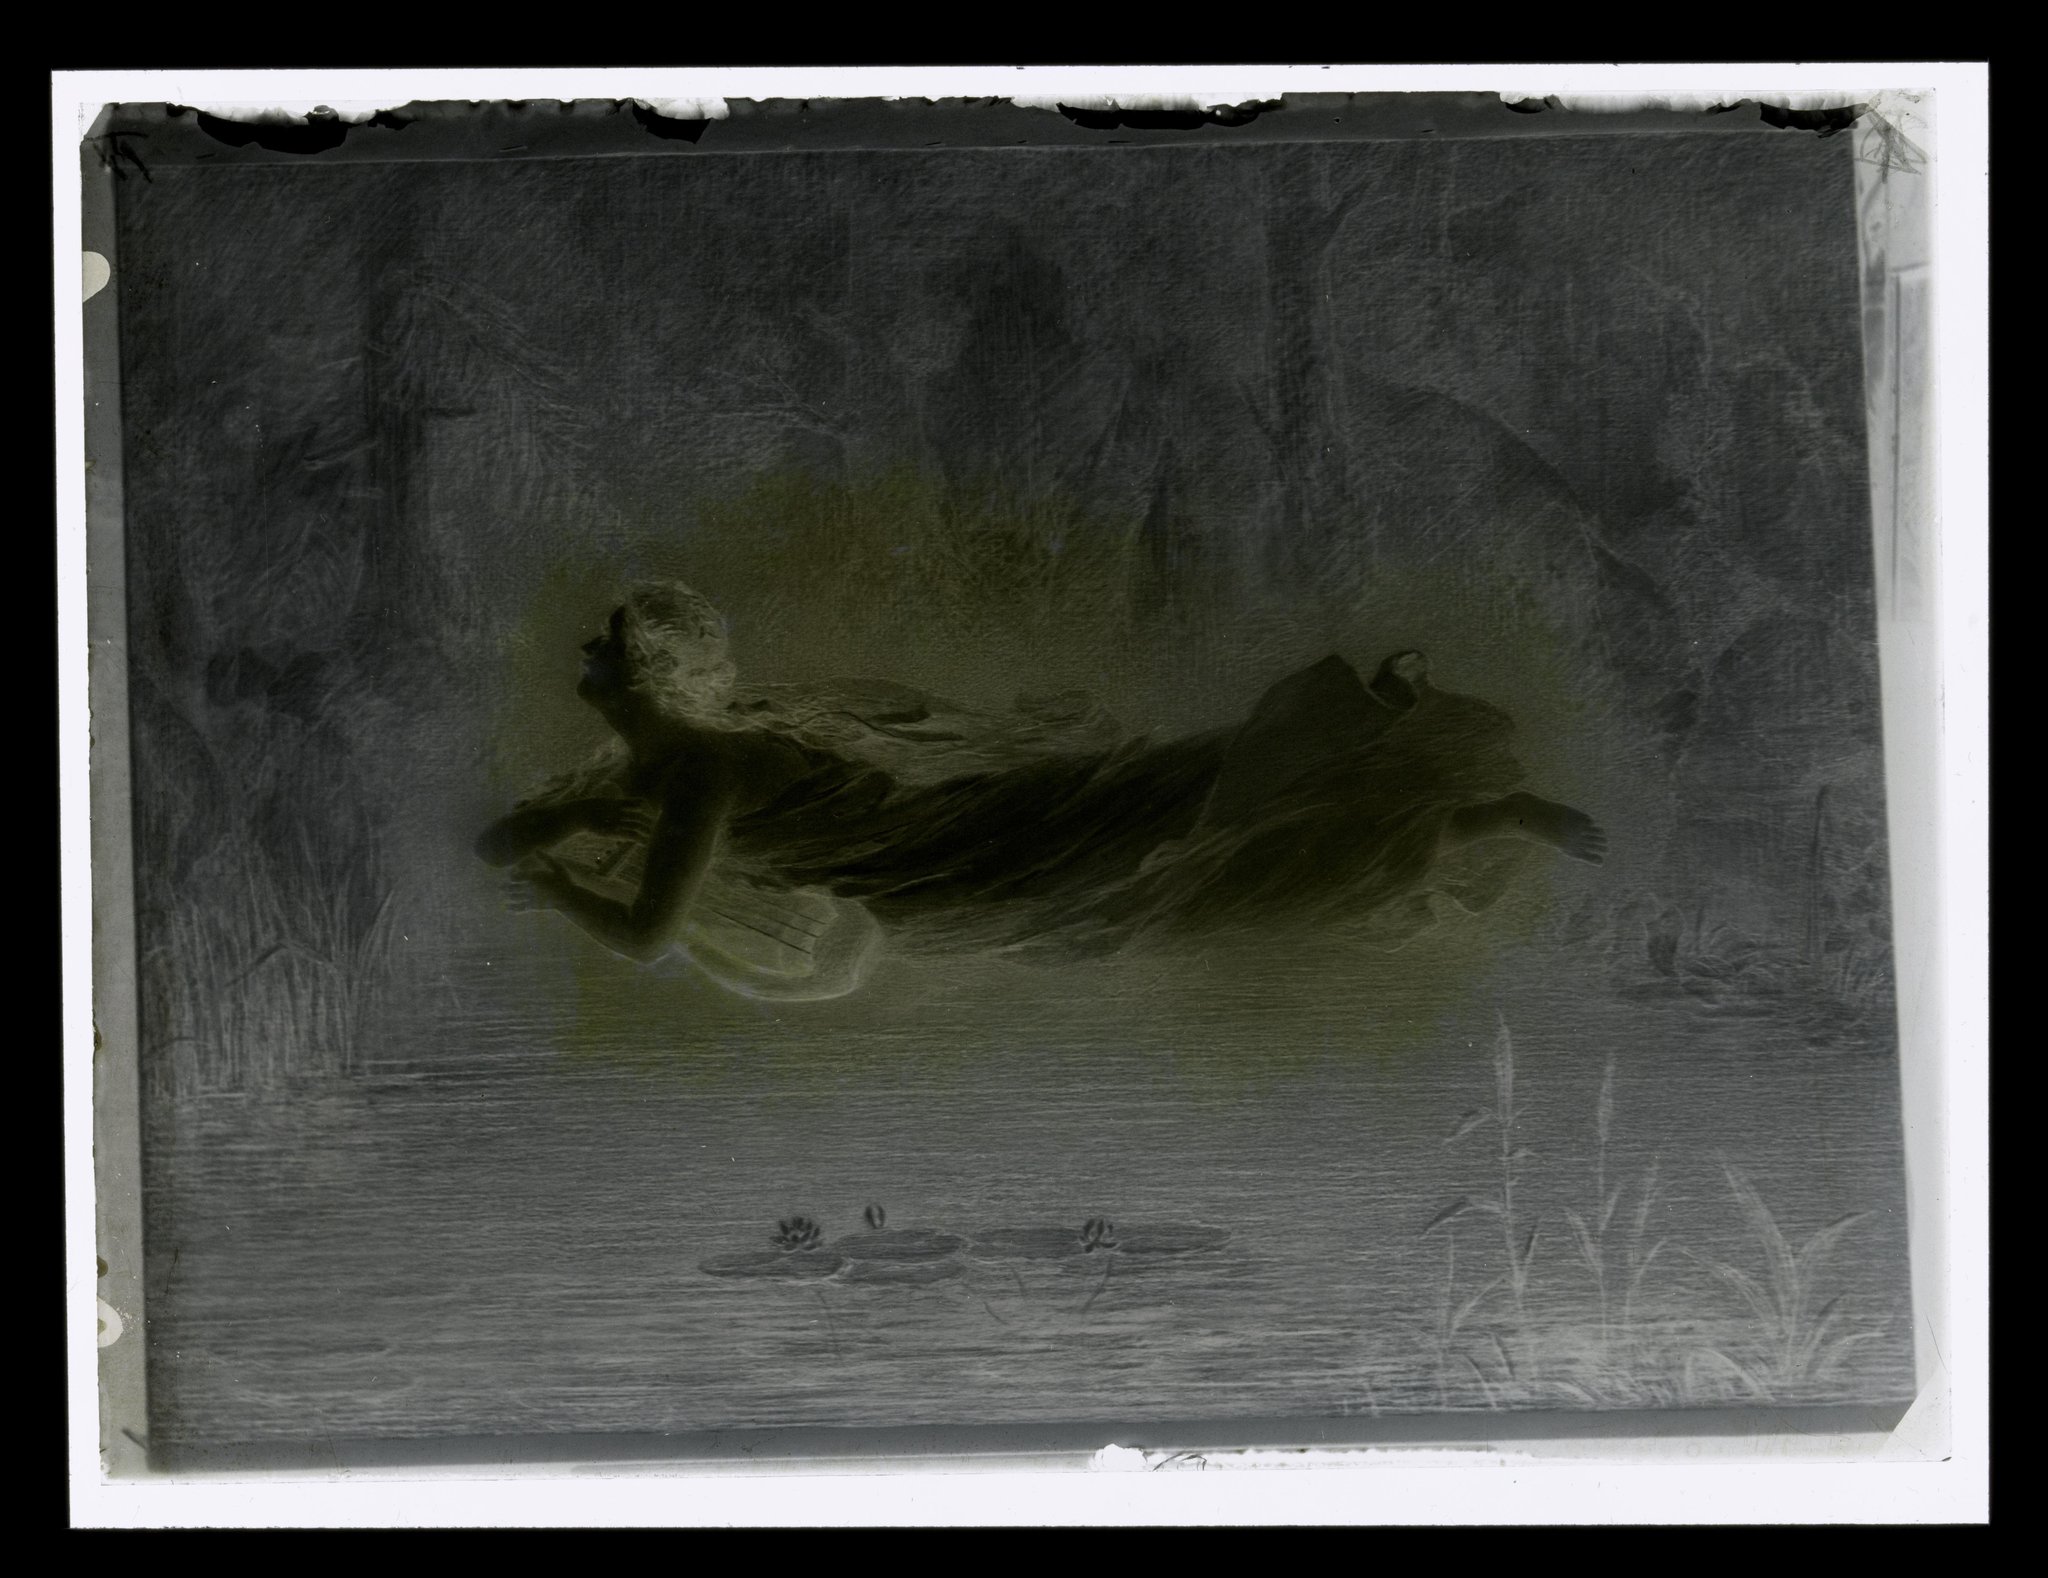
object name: glasnegatief, glasplaatnegatief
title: Fotoreproductie van een schilderij voorstellende een engel met luit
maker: laurens lodewijk kleijn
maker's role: draughtsman, painter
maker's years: 1826-1909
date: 1865-1900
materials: glass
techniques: collodion process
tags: picture, painting, angels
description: Onderdeel van groep glasnegatieven uit de nalatenschap van de schilder Laurens Lodewijk Kleijn, stillevens, portretten, zelfportretten en kunstreproducties.